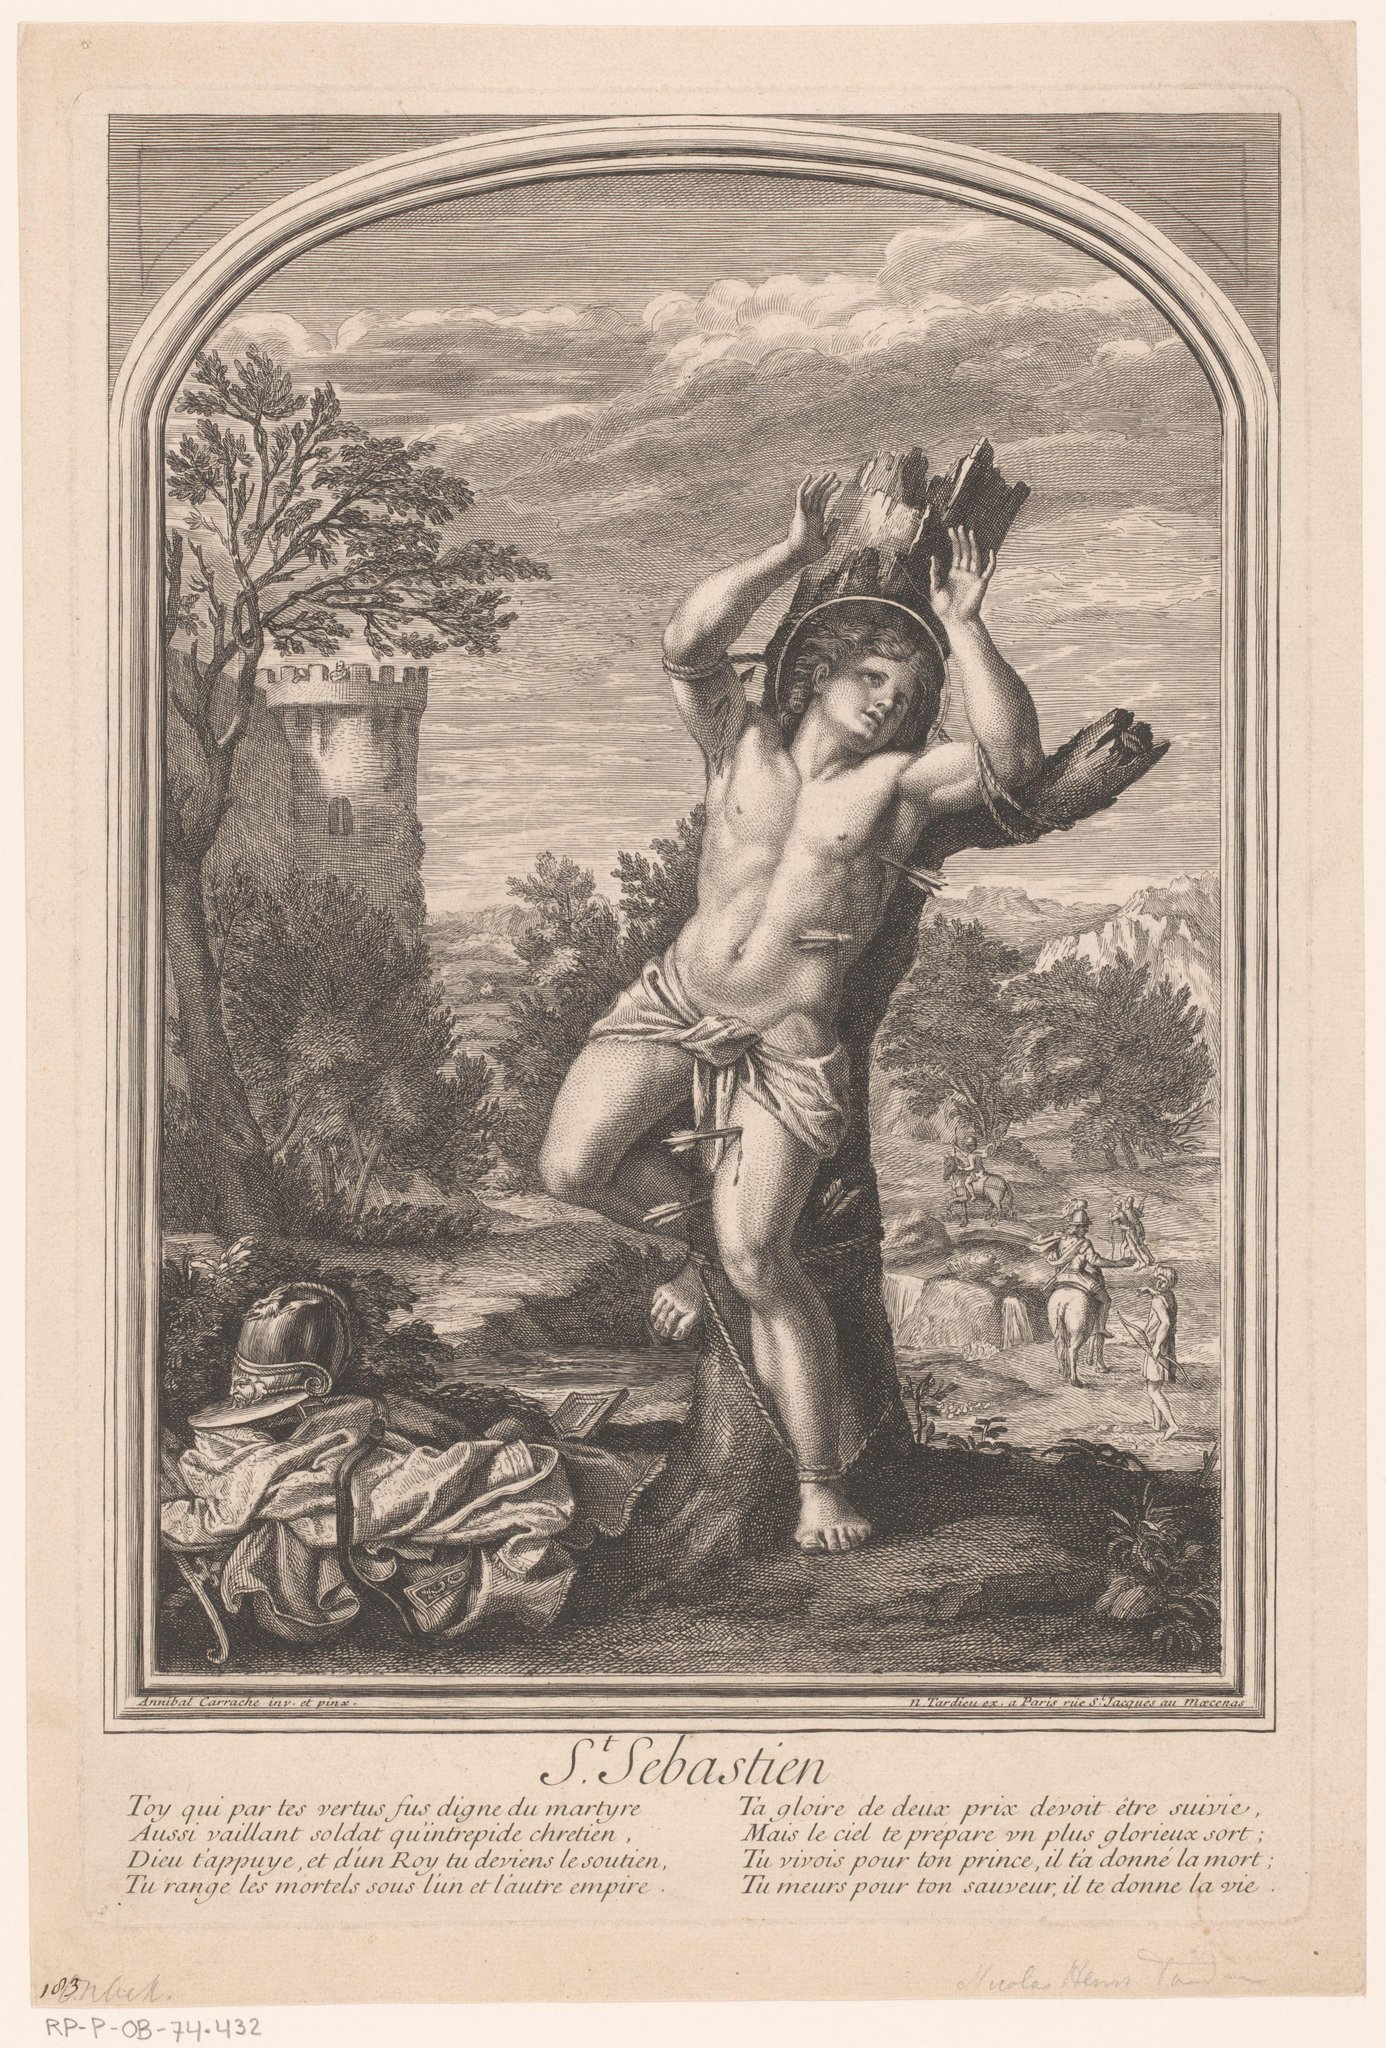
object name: print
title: St. Sebastien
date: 1684-1749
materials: paper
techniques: engraving, etching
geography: paris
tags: st. sebastian, tied to a tree or a pillar, is pierced by arrows, the martyr sebastian; possible attributes: arrow(s), bow, tree-trunk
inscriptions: collector's mark: Lugt 240, number: ‘183’